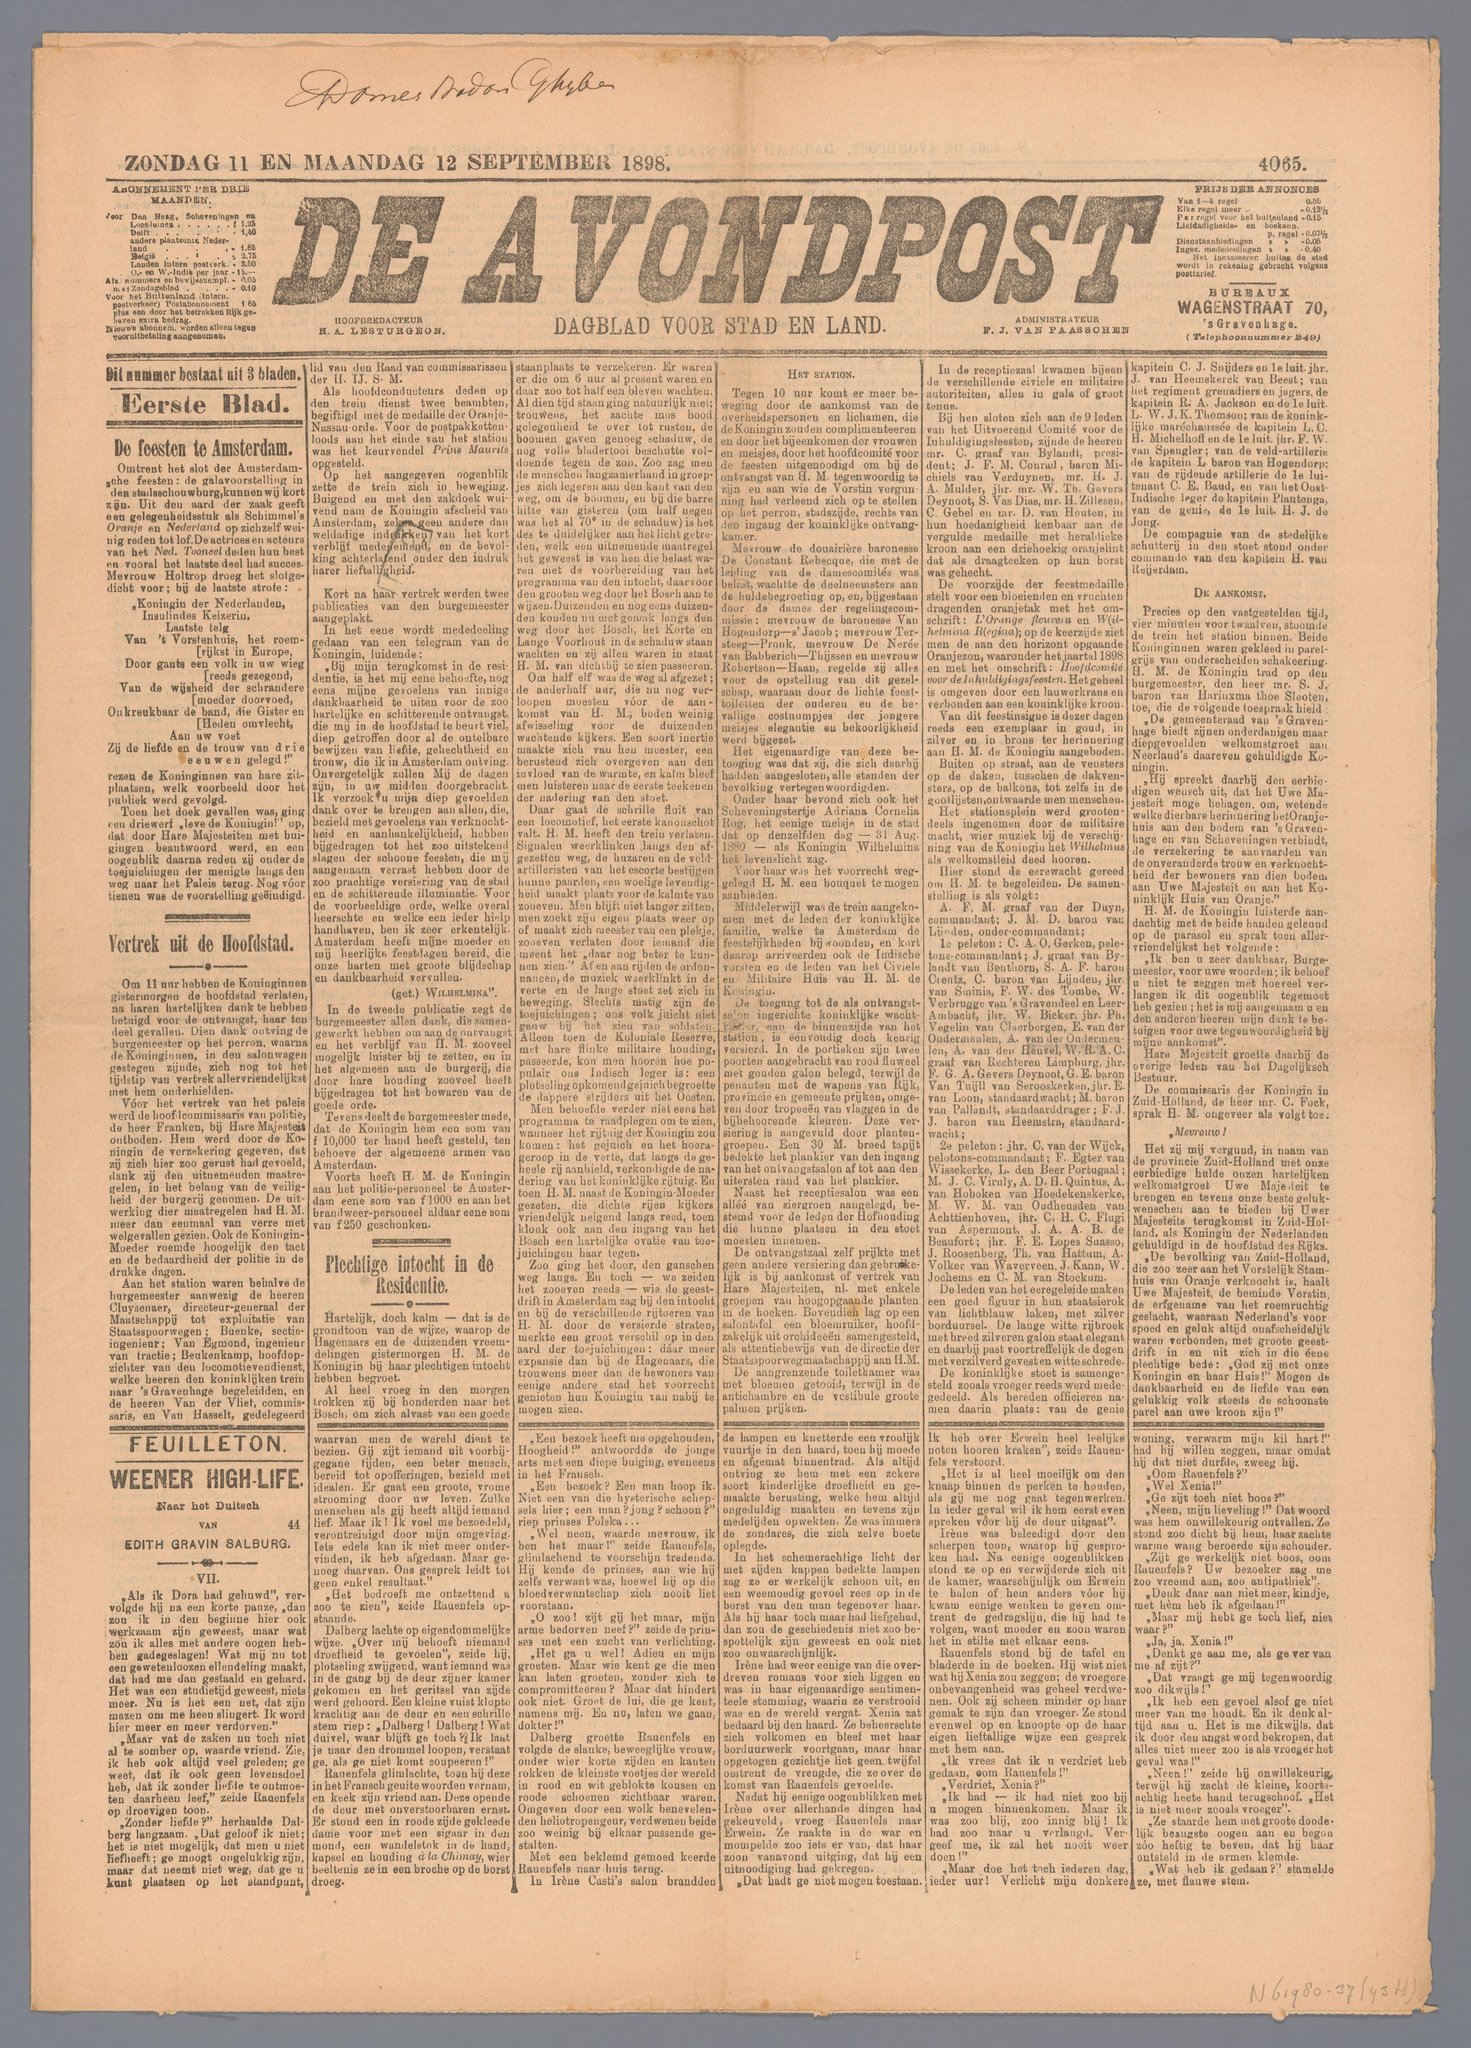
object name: newspaper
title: de Avondpost; dagblad voor stad en land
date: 1898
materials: paper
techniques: printing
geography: the hague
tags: the hague, wilhelmina of the netherlands, netherlands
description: Eén van een serie kranten, nrs. 4056 t/m 4073, van "de Avondpost" met berichten over de inhuldiging van koningin Wilhelmina 1898.